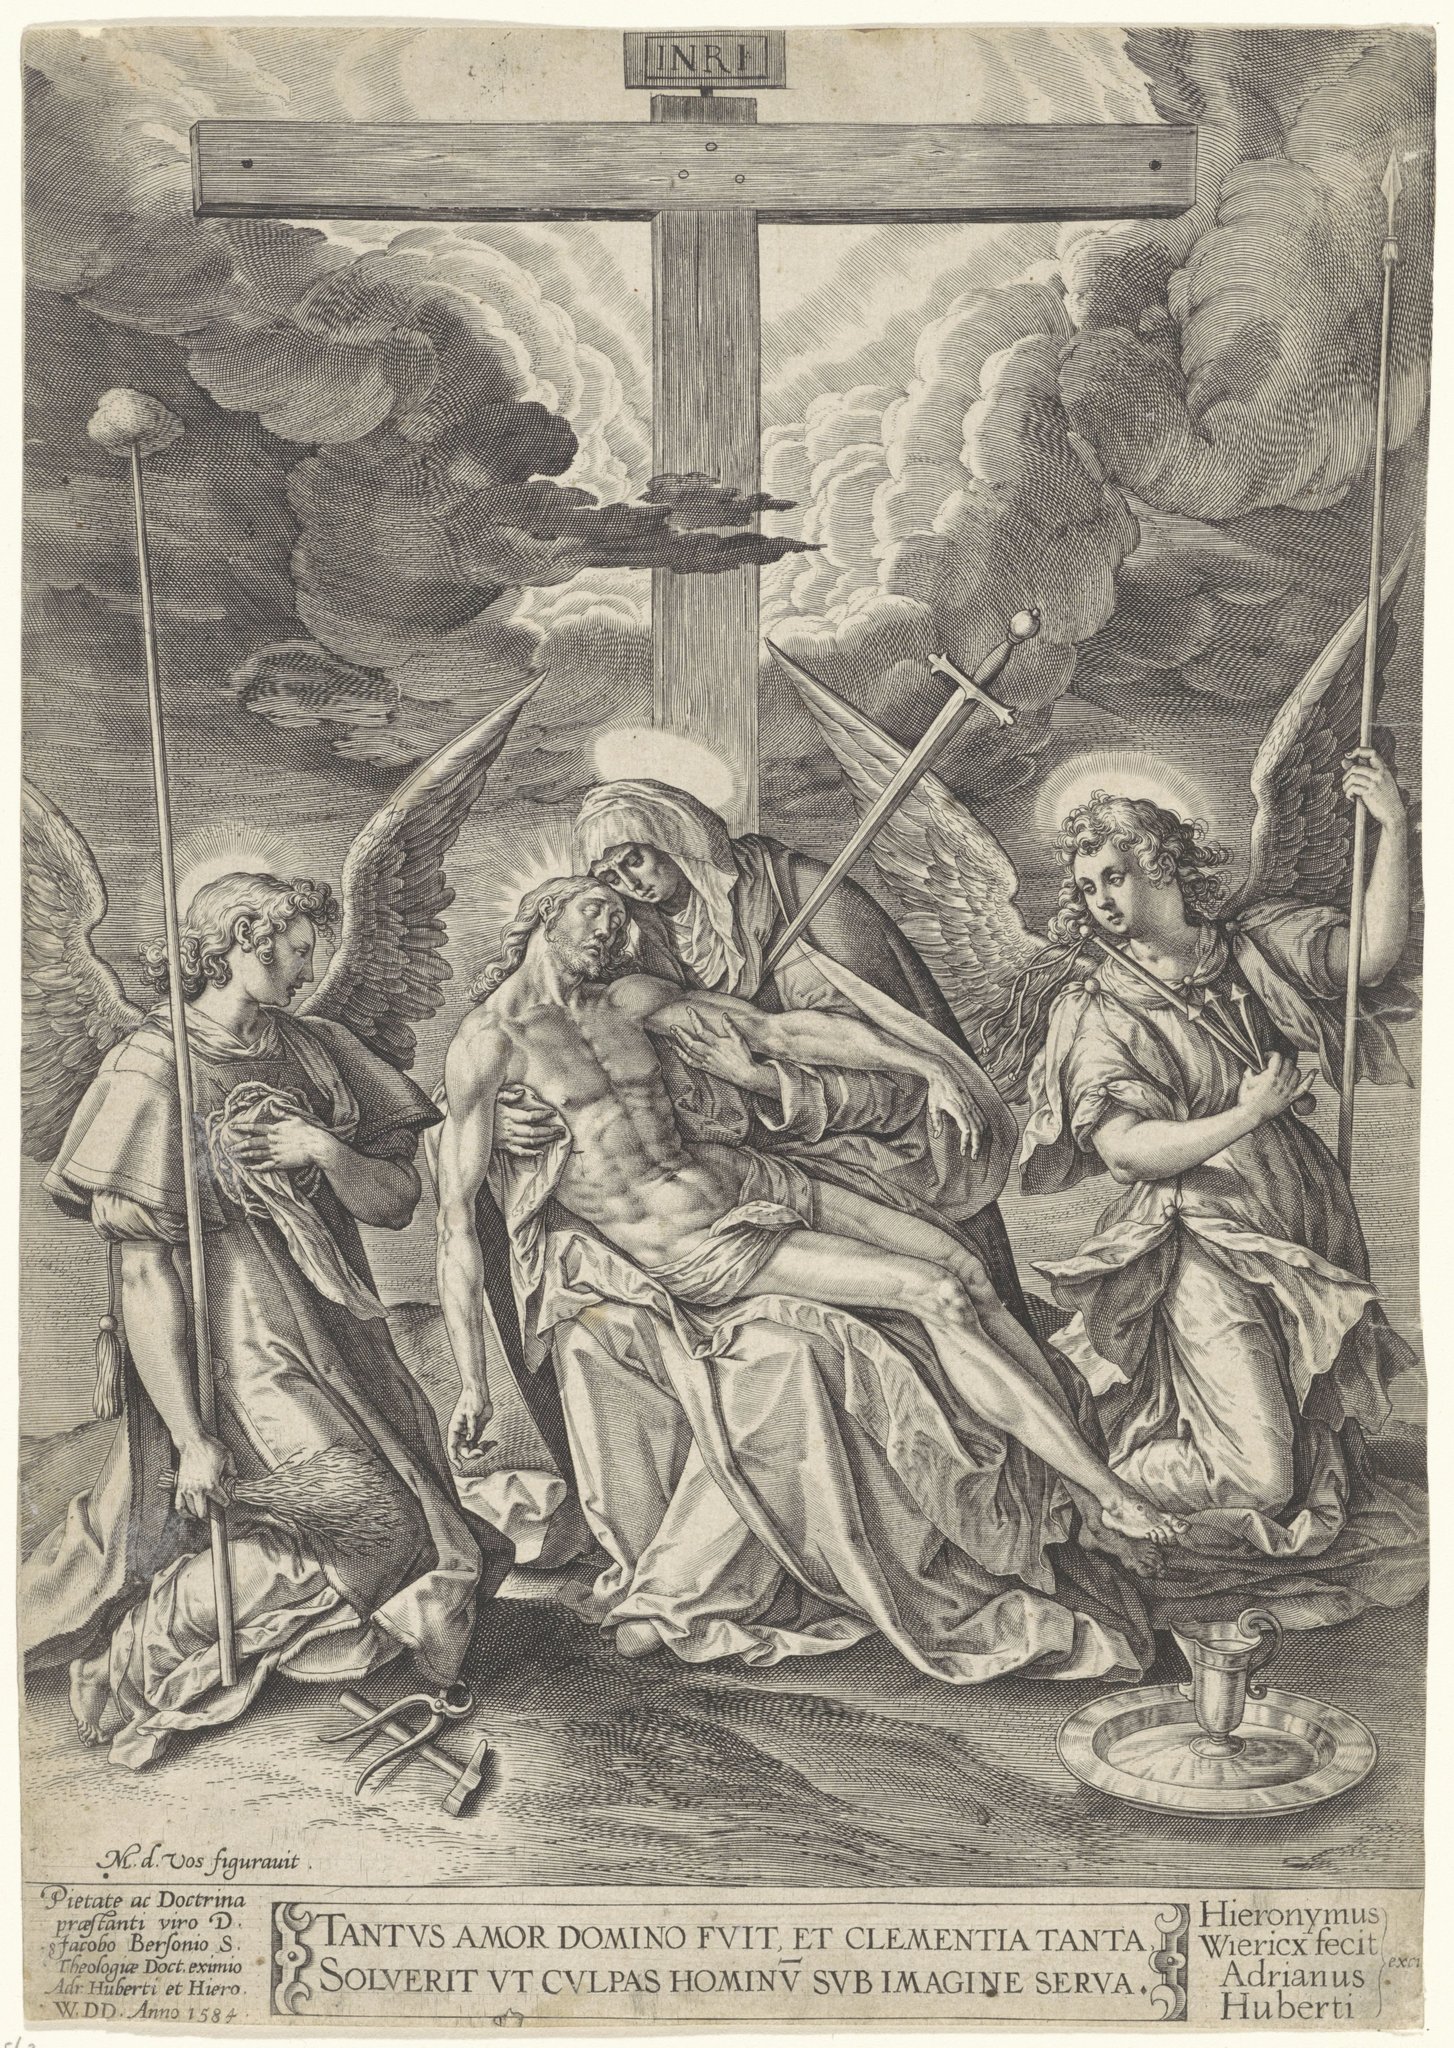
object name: print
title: Piëta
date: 1584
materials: paper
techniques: engraving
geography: antwerp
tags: the dead christ in mary's lap (+ angel(s)), single instruments of the passion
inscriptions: number: ‘30x’, collector's mark: Lugt 2228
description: Maria weent met het dode lichaam van Christus op haar schoot aan de voet van het kruis. Een zwaard is in haar hart gestoken. Ze is vergezeld door twee engelen, die passiewerktuigen in de hand houden. In het kader in de marge een tweeregelig onderschrift in het Latijn.